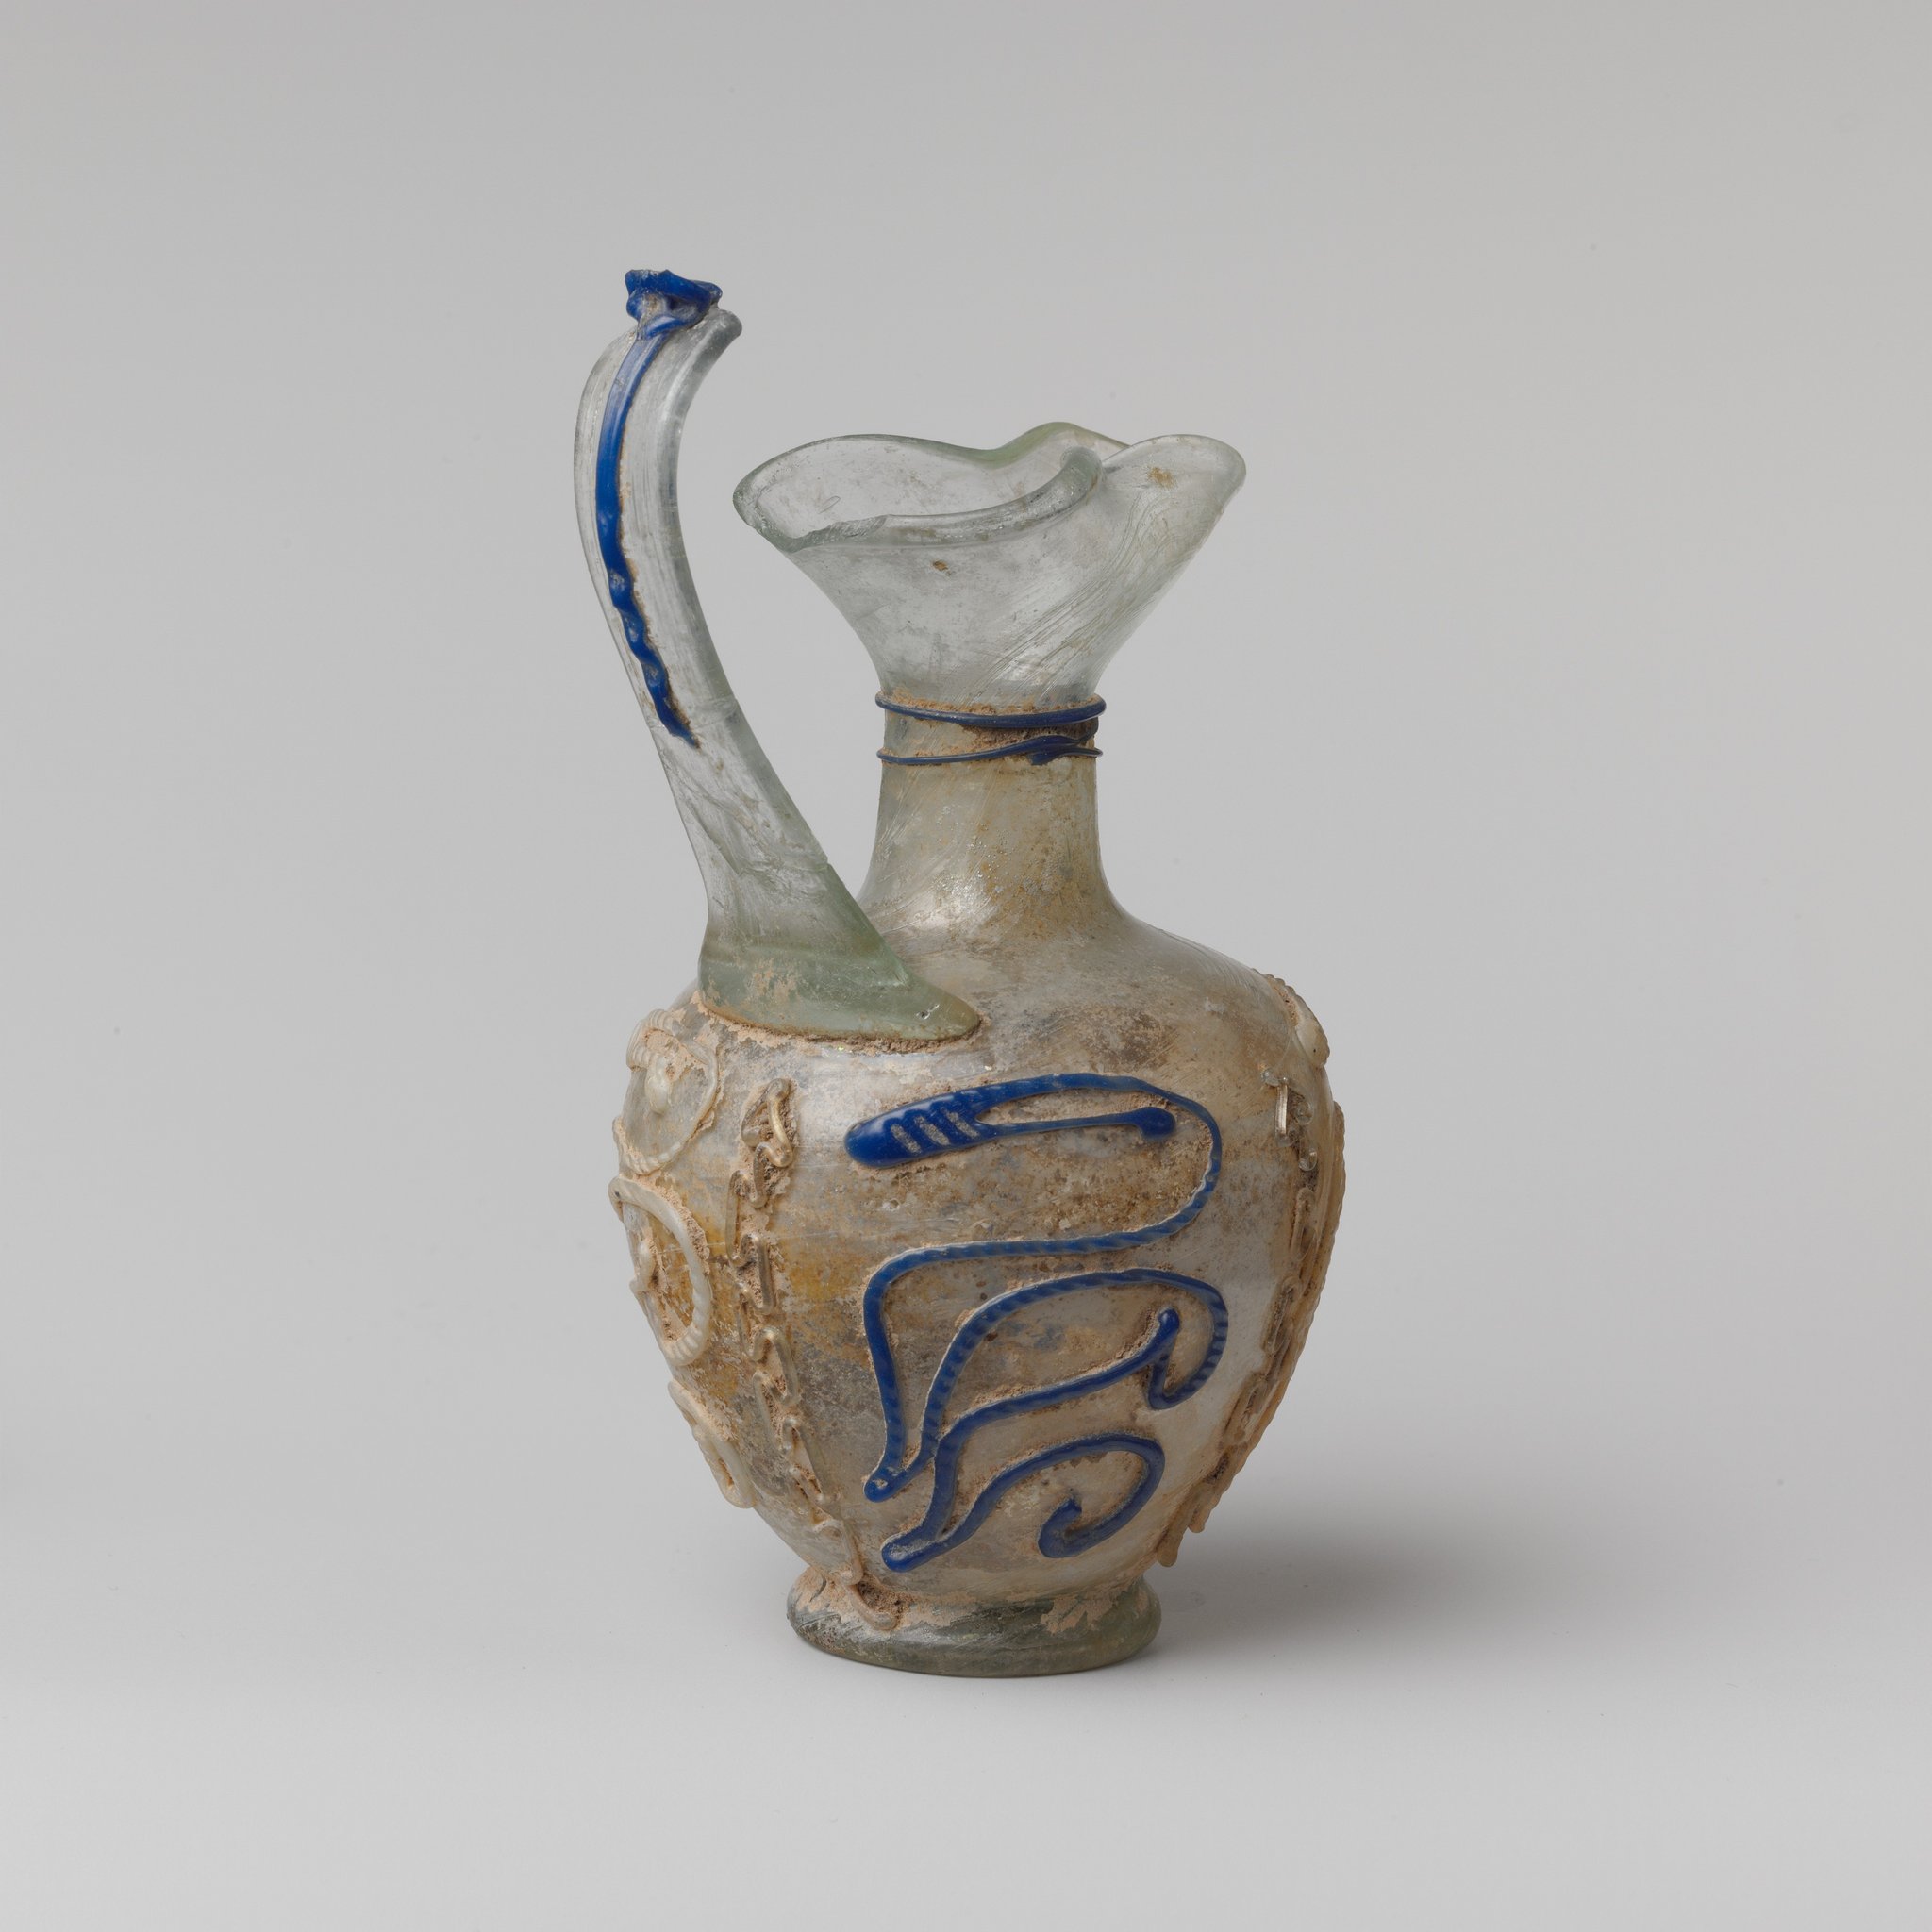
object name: jug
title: Glass jug (oinochoe) with snake-thread decoration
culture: roman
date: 101-300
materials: glass